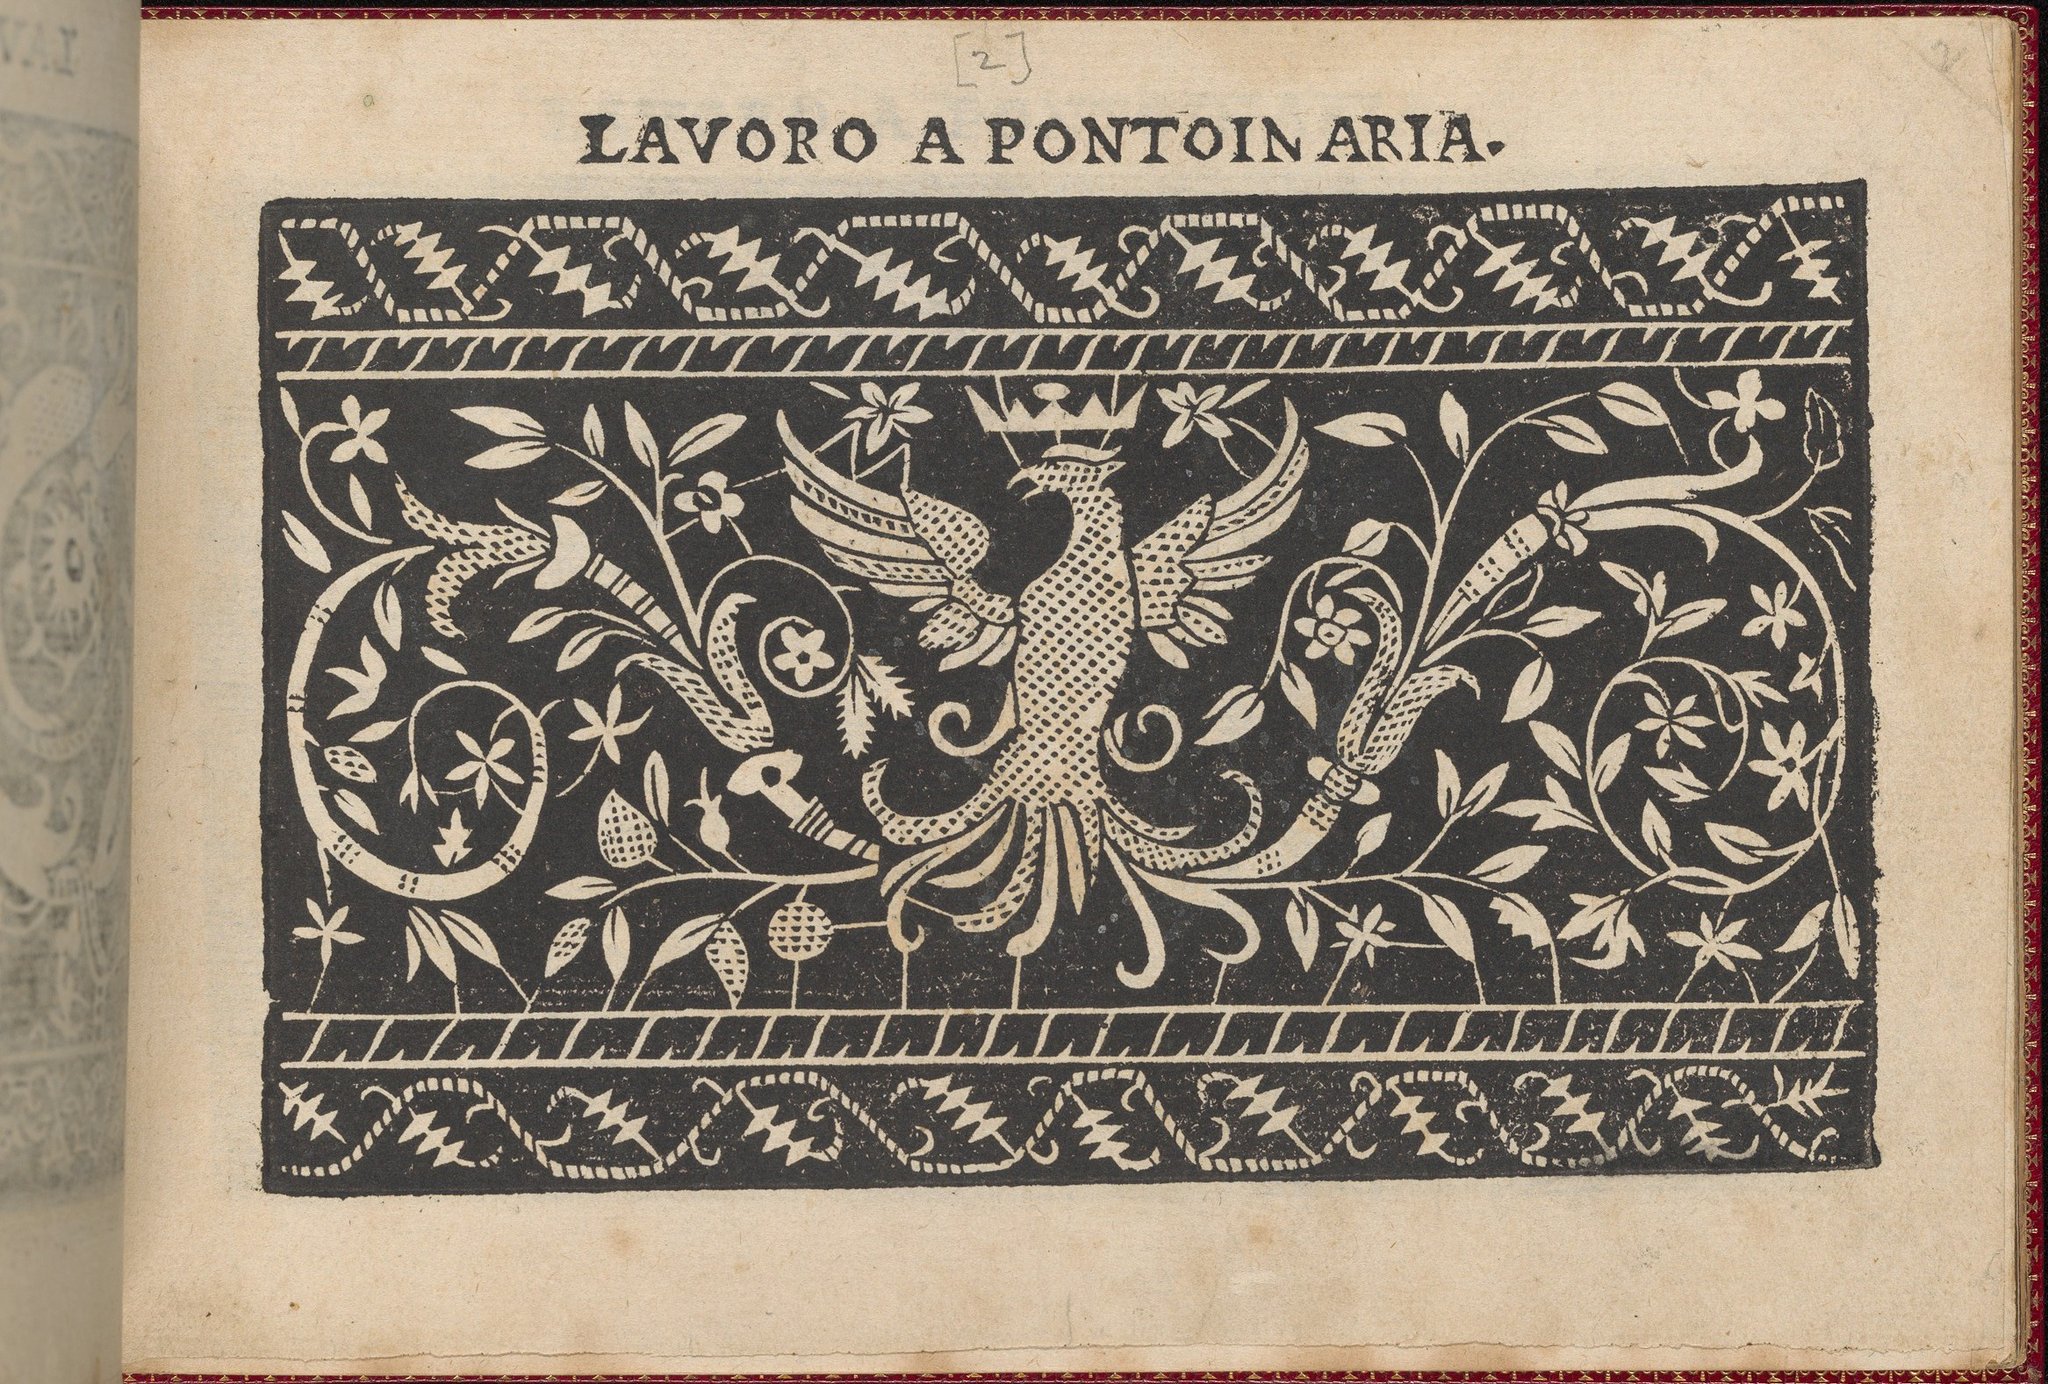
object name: book print ornament architecture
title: Pretiosa Gemma delle virtuose donne, page 4 (recto)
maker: isabella catanea parasole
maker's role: author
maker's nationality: italian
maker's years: 1565-1625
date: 1600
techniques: woodcut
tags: birds,ornament